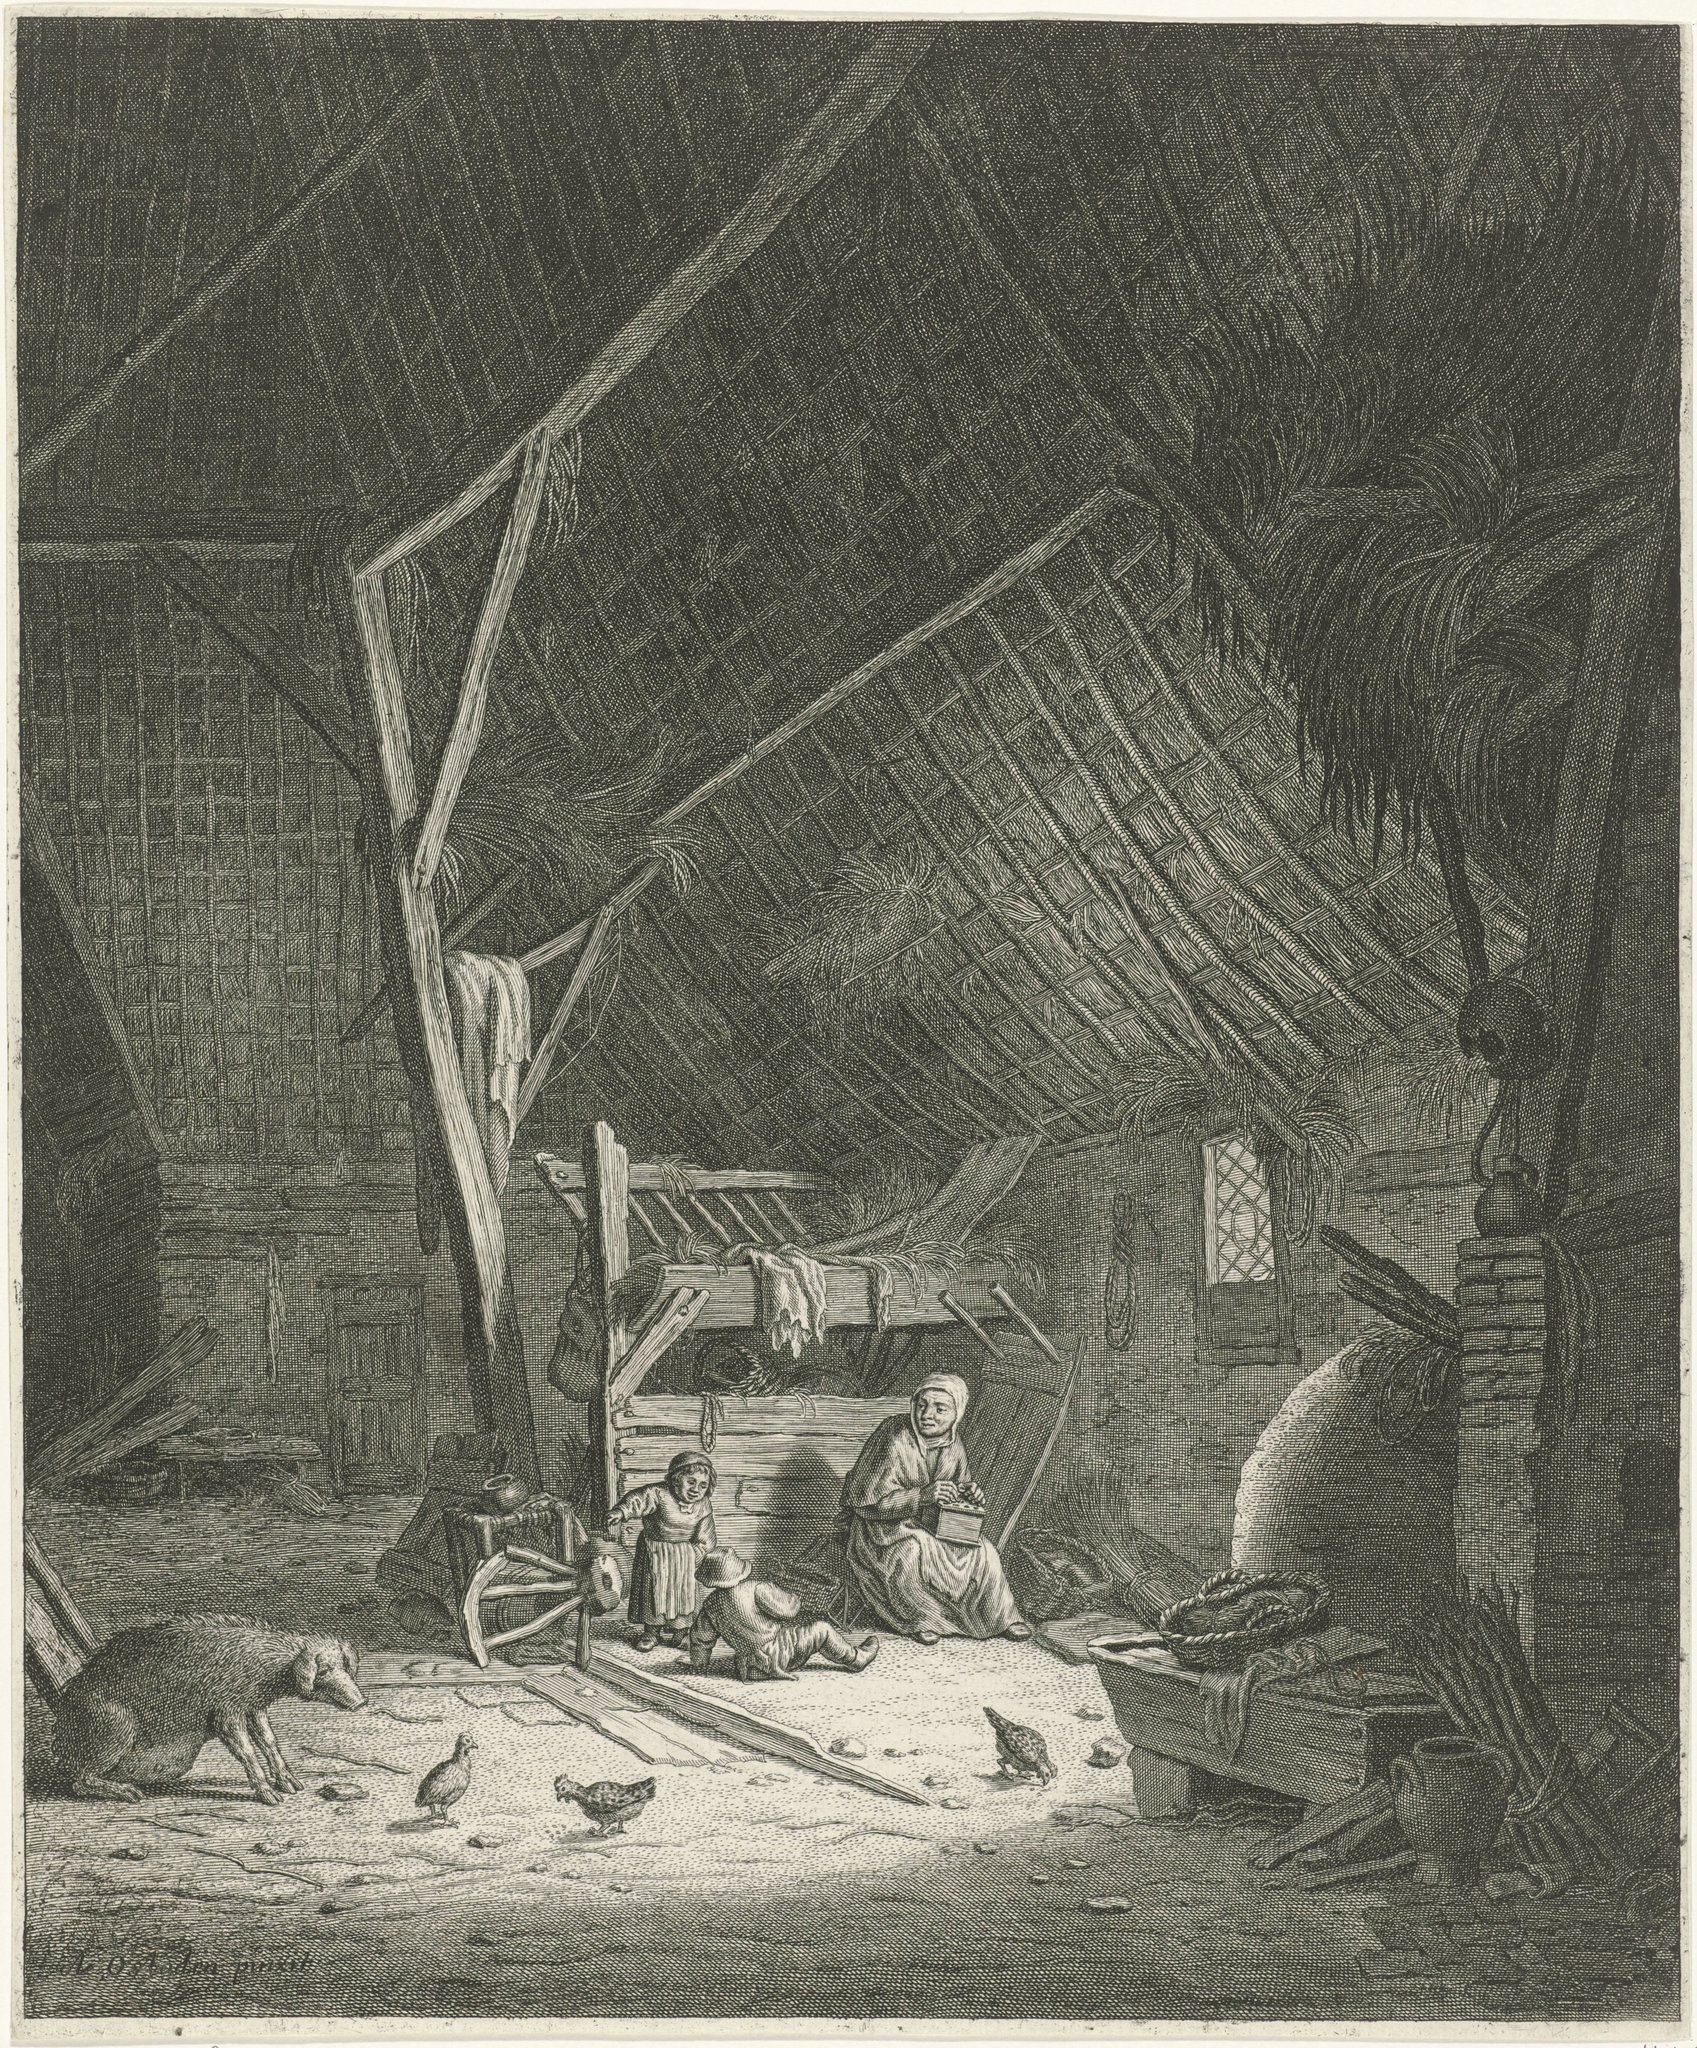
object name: print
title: Interieur van een schuur met moeder en twee kinderen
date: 1630-1673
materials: paper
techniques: etching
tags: mother and baby or young child, farm (building) - aa - civic architecture: inside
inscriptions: collector's mark: Lugt 240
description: Interieur van een schuur met een moeder, twee kinderen, kippen en een zwijn.